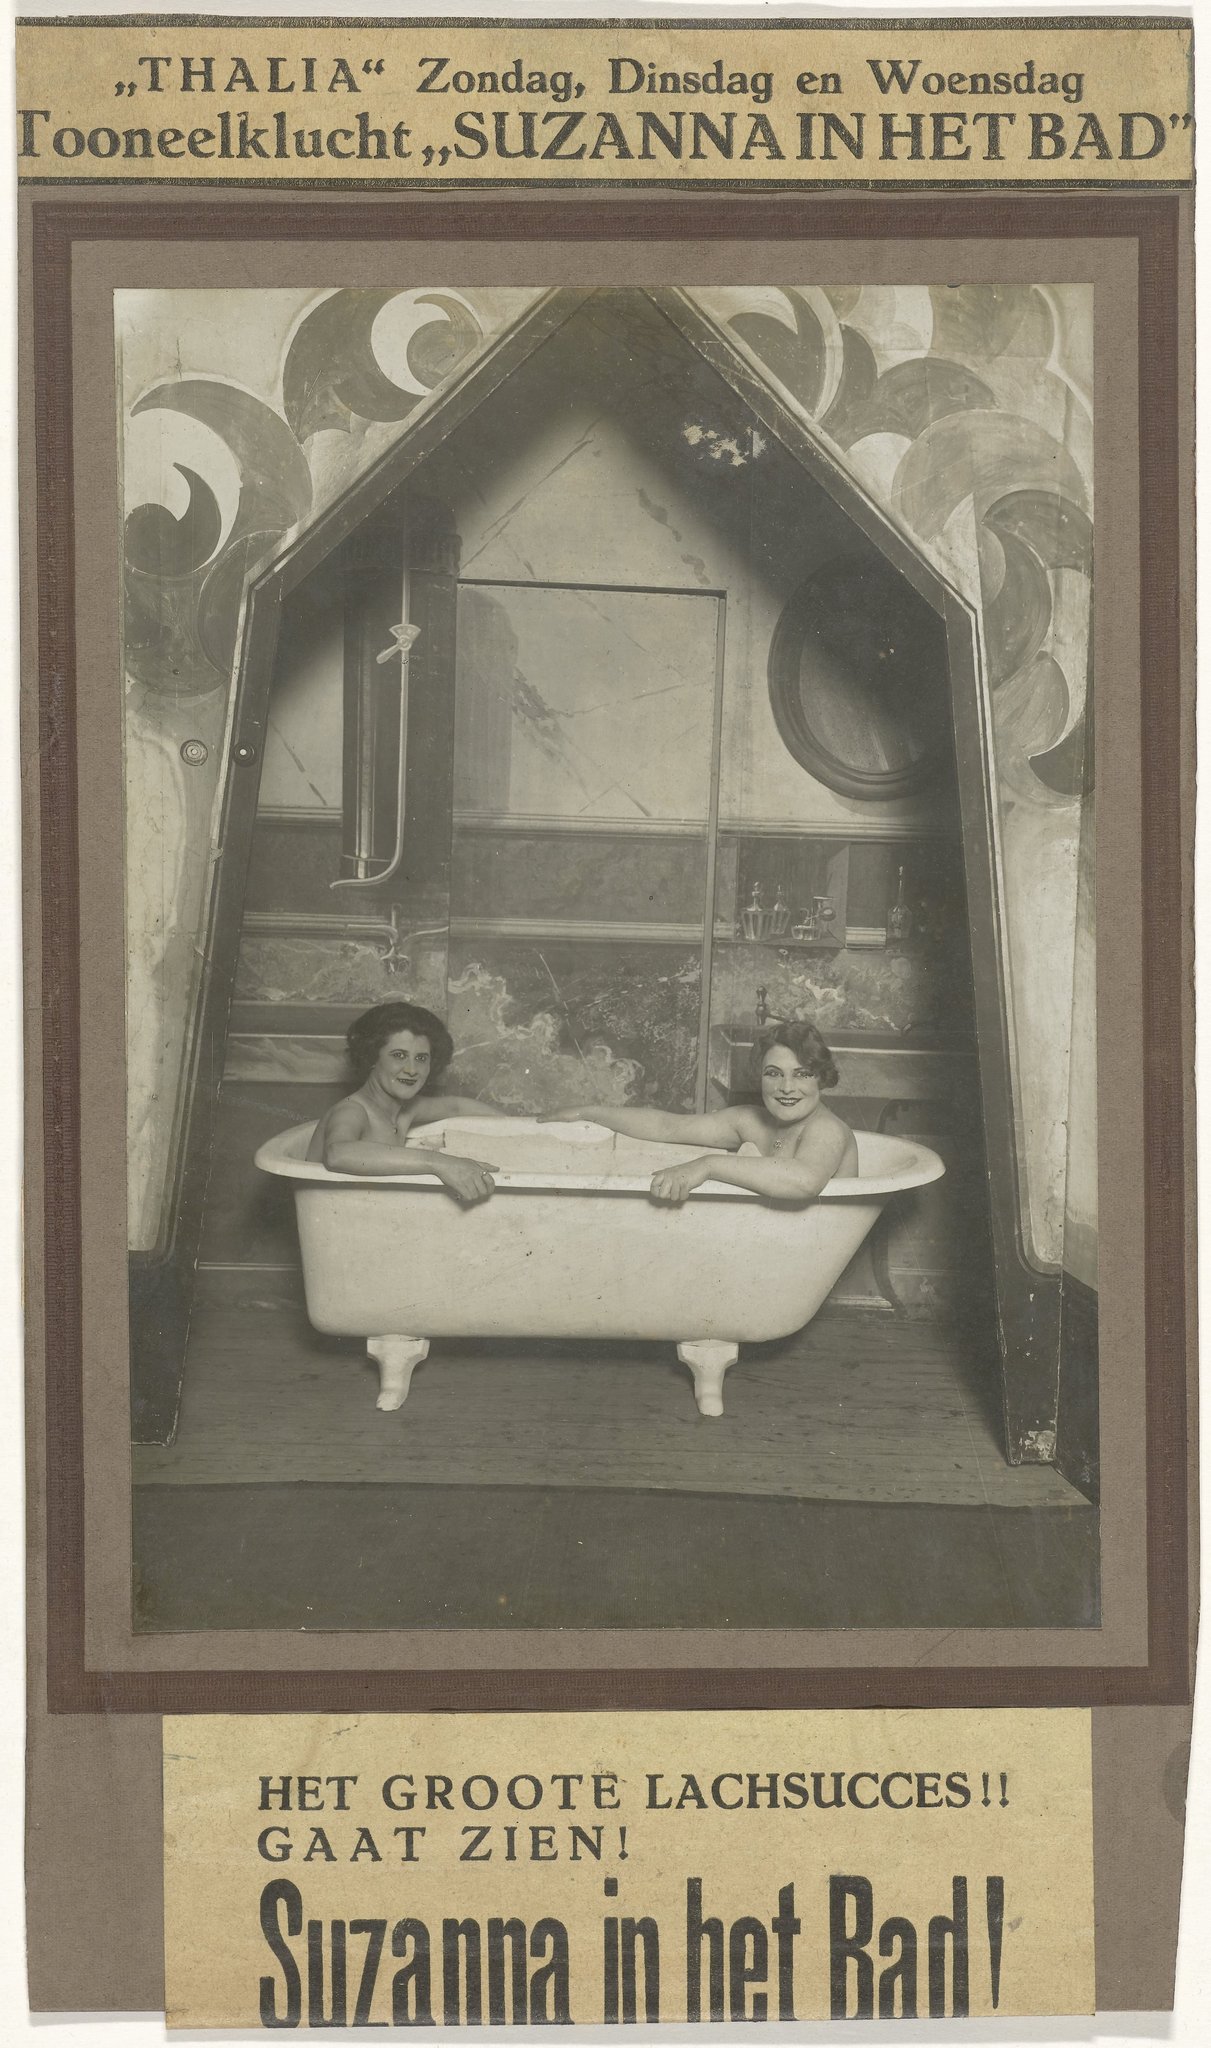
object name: photograph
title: Scene uit 'Suzanna in het bad': twee actrices in badkuip met reclametekst rondom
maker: Anonymous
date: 1900-1920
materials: cardboard, photographic support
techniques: gelatin silver print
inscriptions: inscription: ‘Het groote lachsucces, Gaat zien! Suzanna in het Bad...’, inscription: ‘c. kater Zaandam’